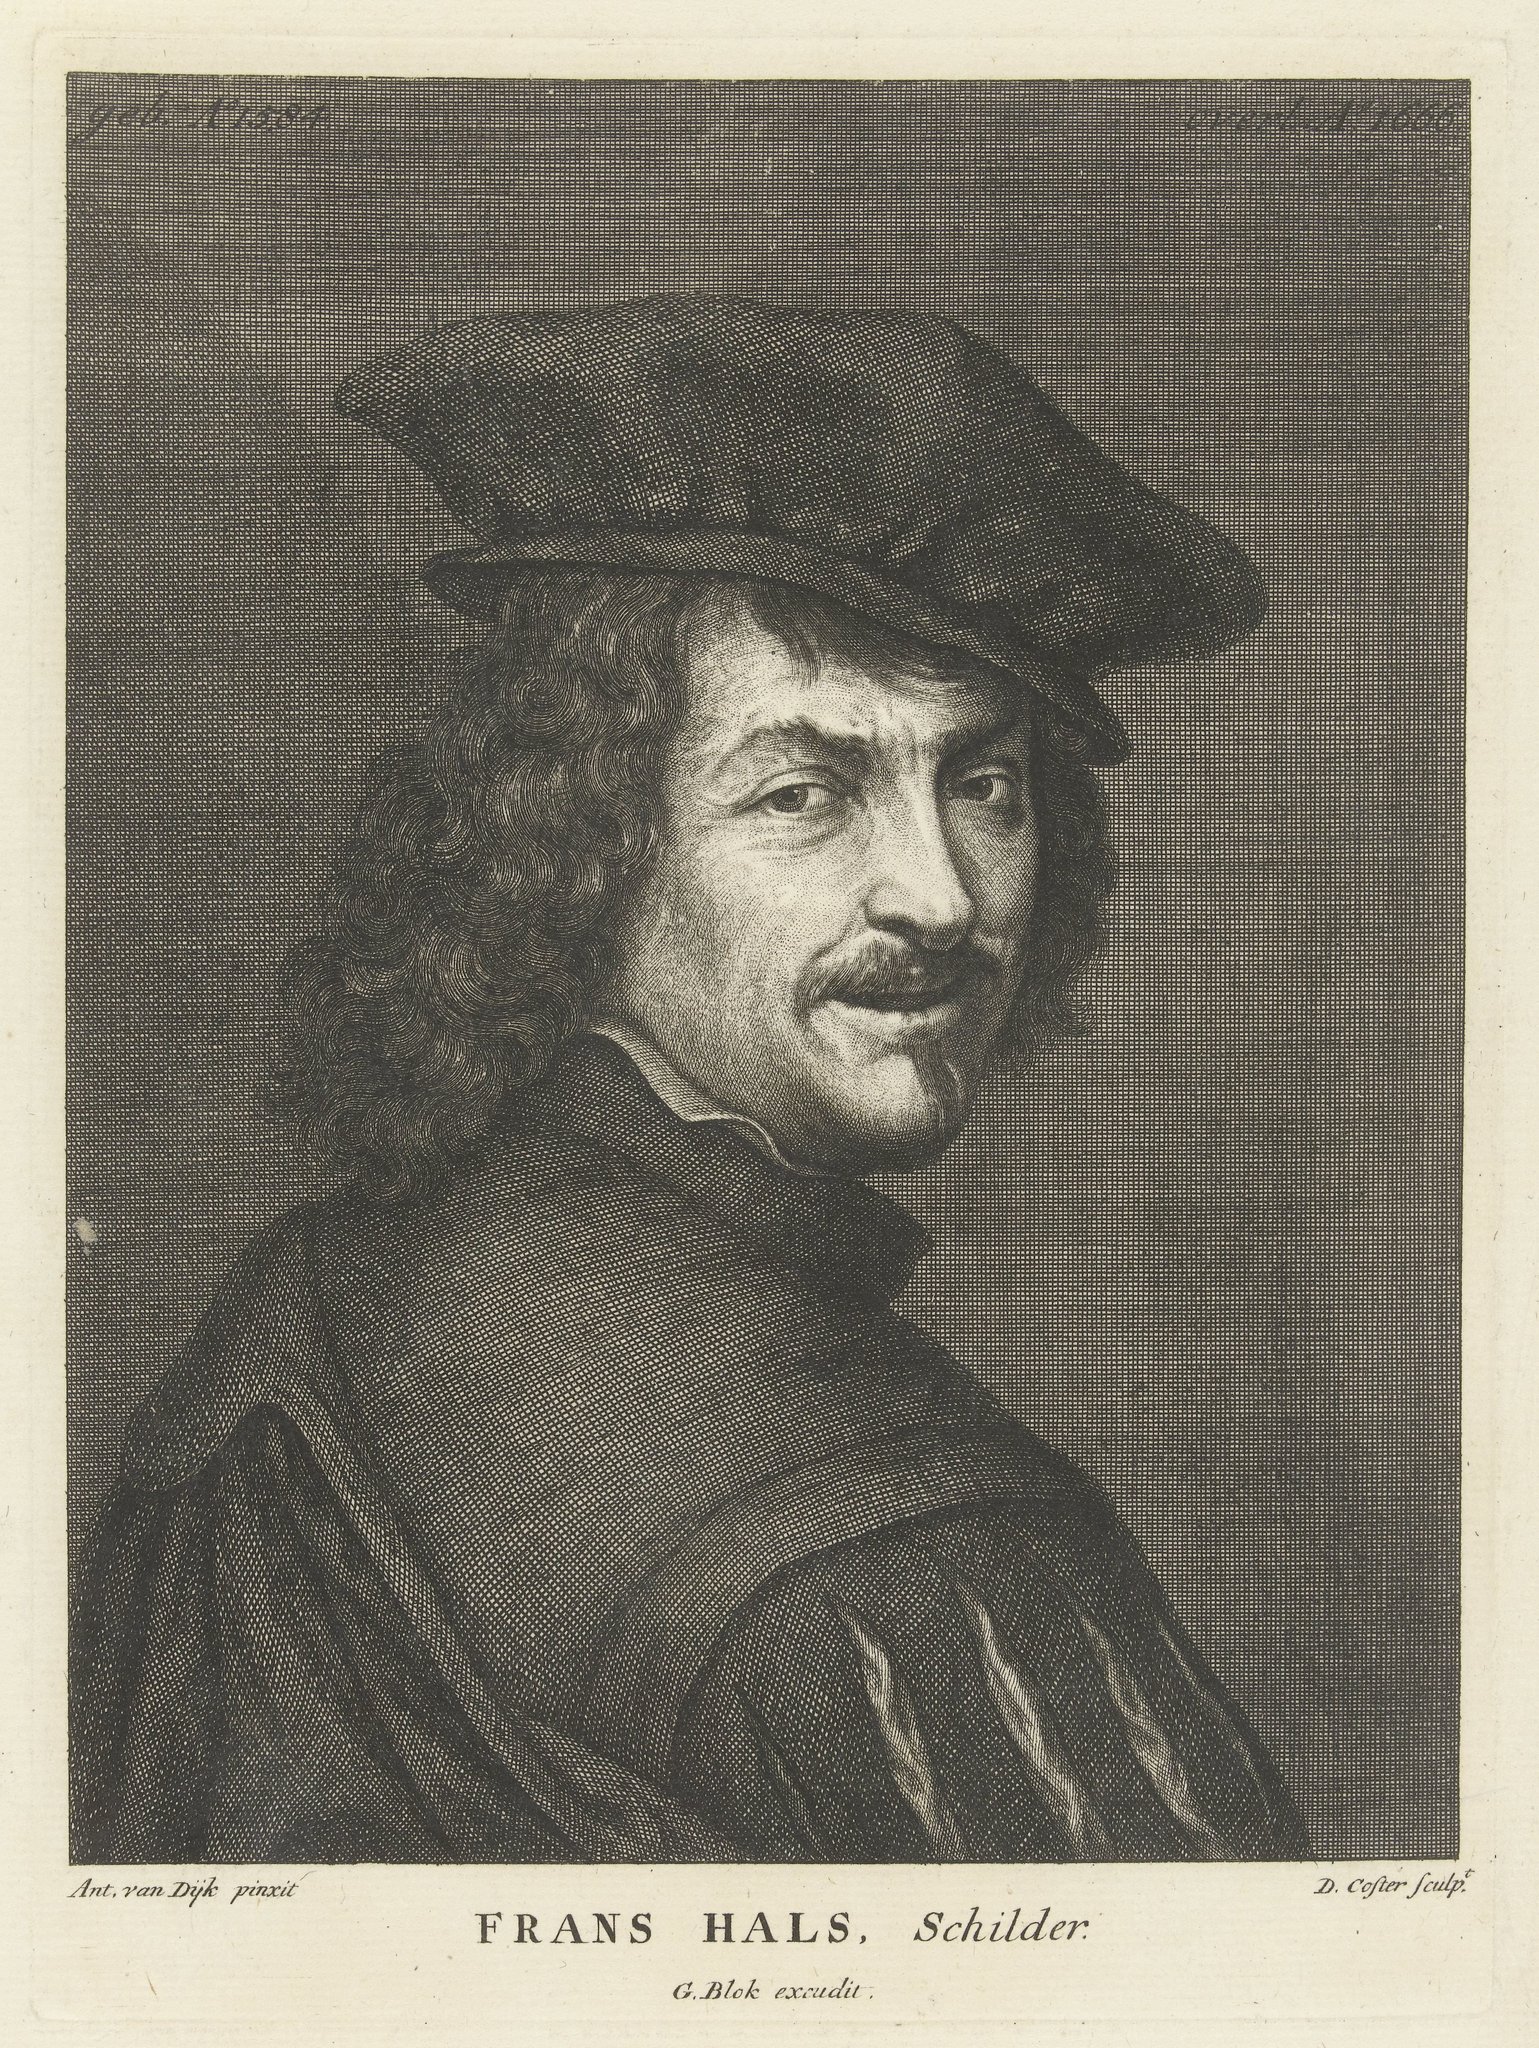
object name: print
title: Portret van de schilder Frans Hals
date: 1732-1743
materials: paper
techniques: engraving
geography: the hague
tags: antwerp, haarlem, draughtsman, frans hals, portrait, self-portrait of painter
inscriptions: collector's mark: Lugt 2228